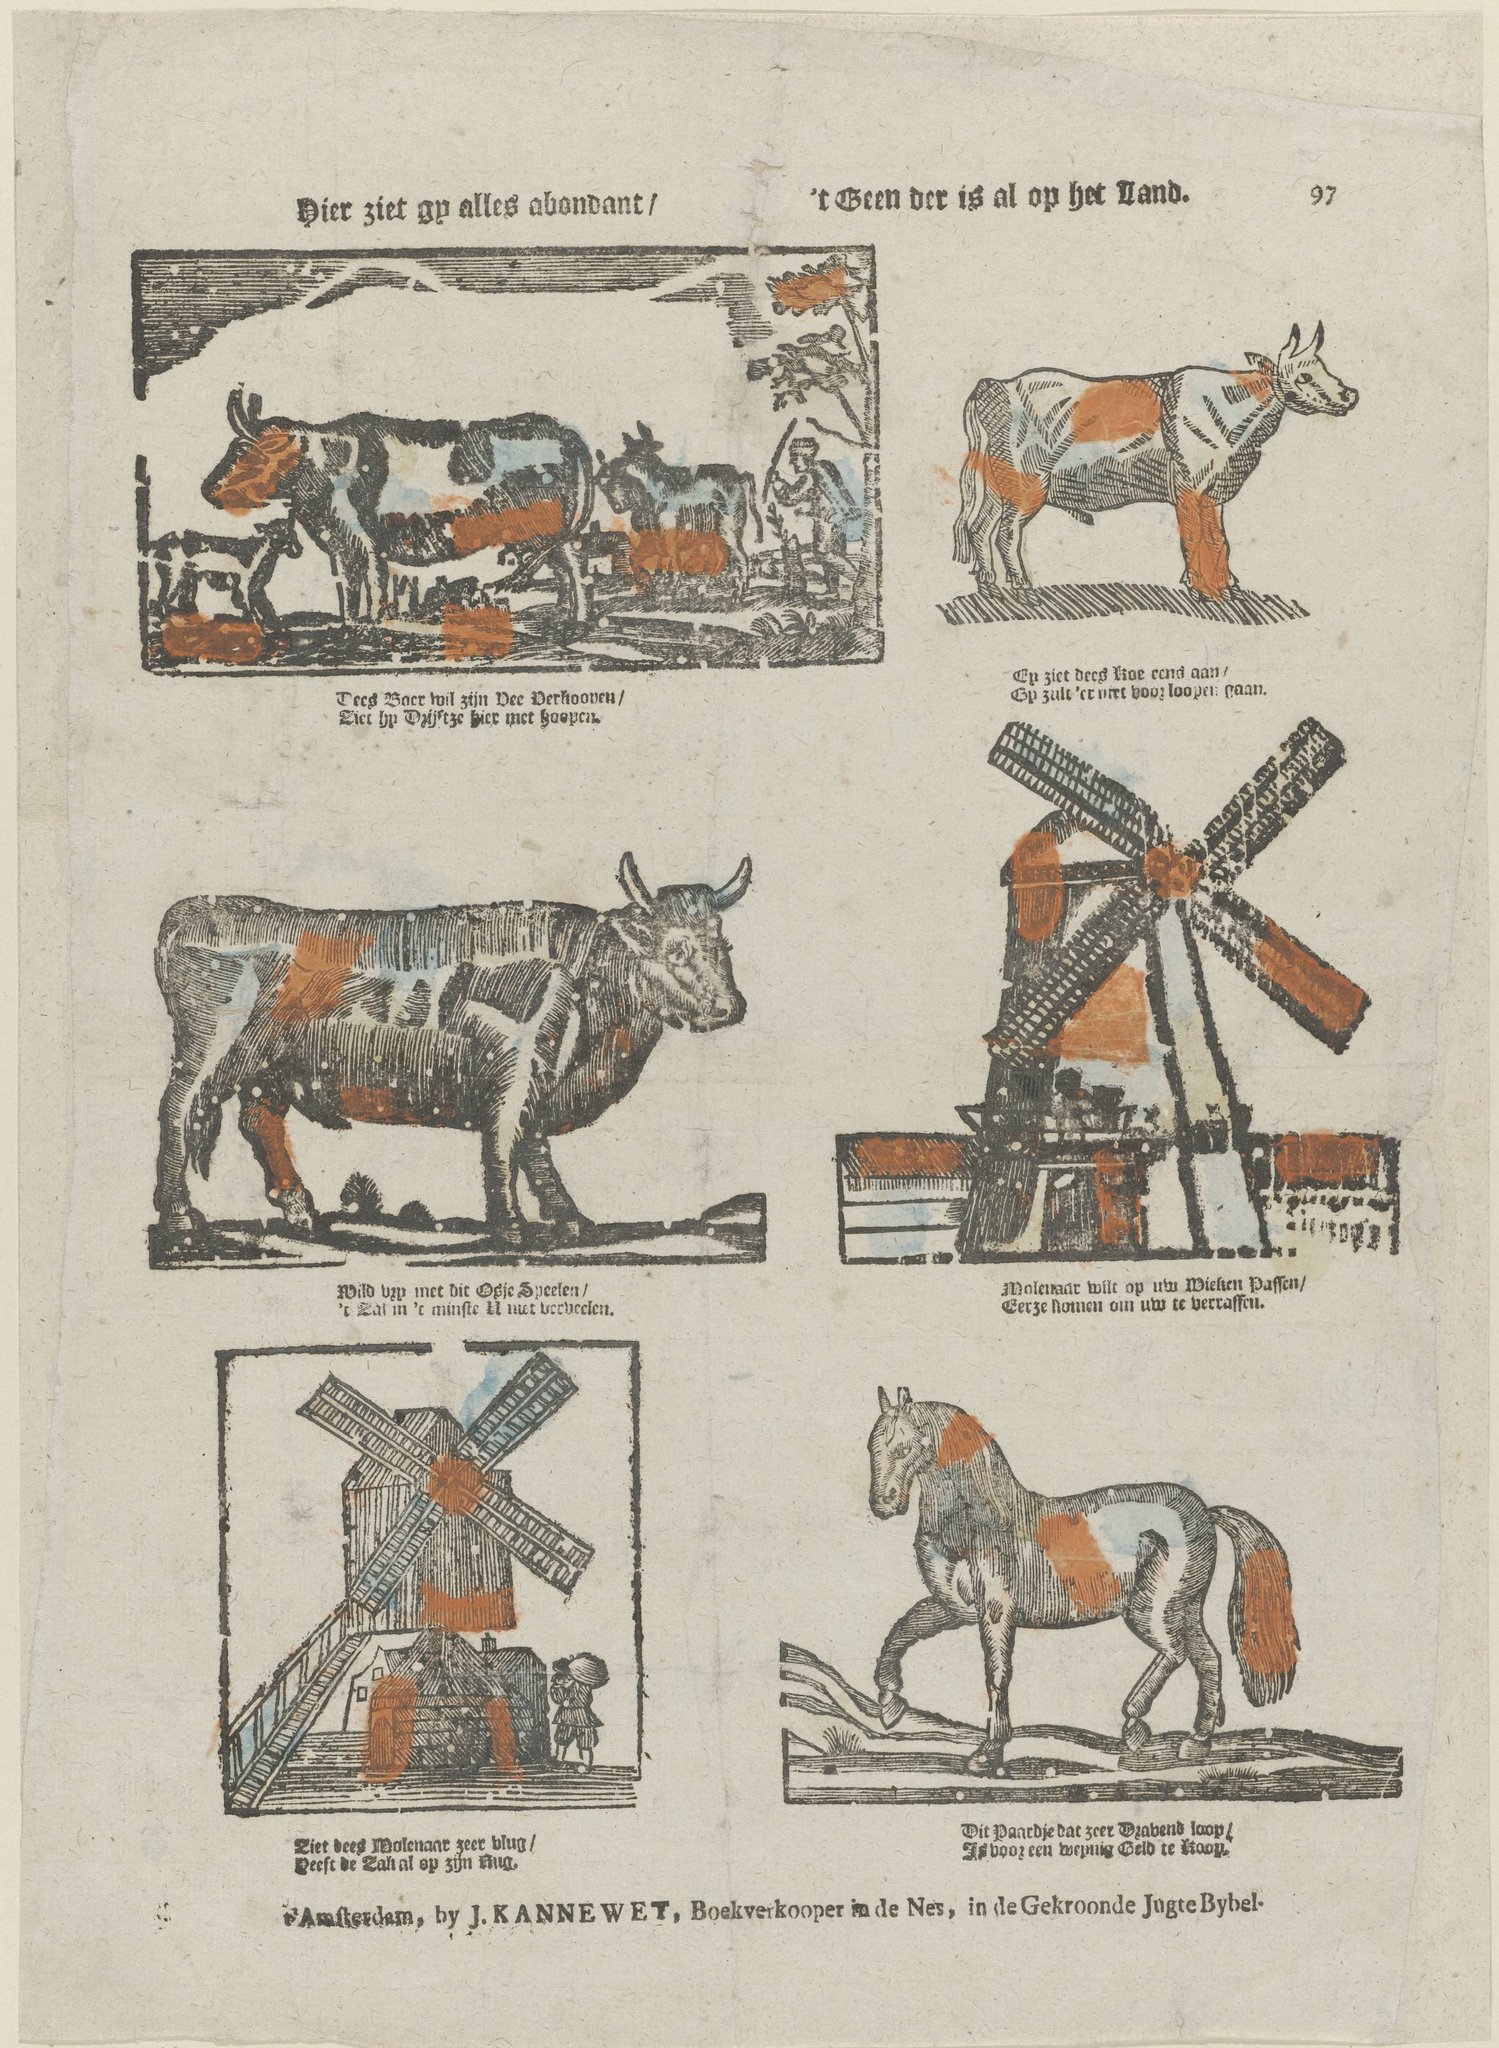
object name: popular print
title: Hier ziet gy alles abondant / 't geen der is al op het Land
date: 1725-1780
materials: paper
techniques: colour, letterpress printing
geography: amsterdam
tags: cow, horse, windmill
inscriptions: collector's mark: Lugt 2760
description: Blad met 6 voorstellingen van koeien, molens en een paard. Onder elke afbeelding een tweergelig vers. genummerd rechtsboven: 97.